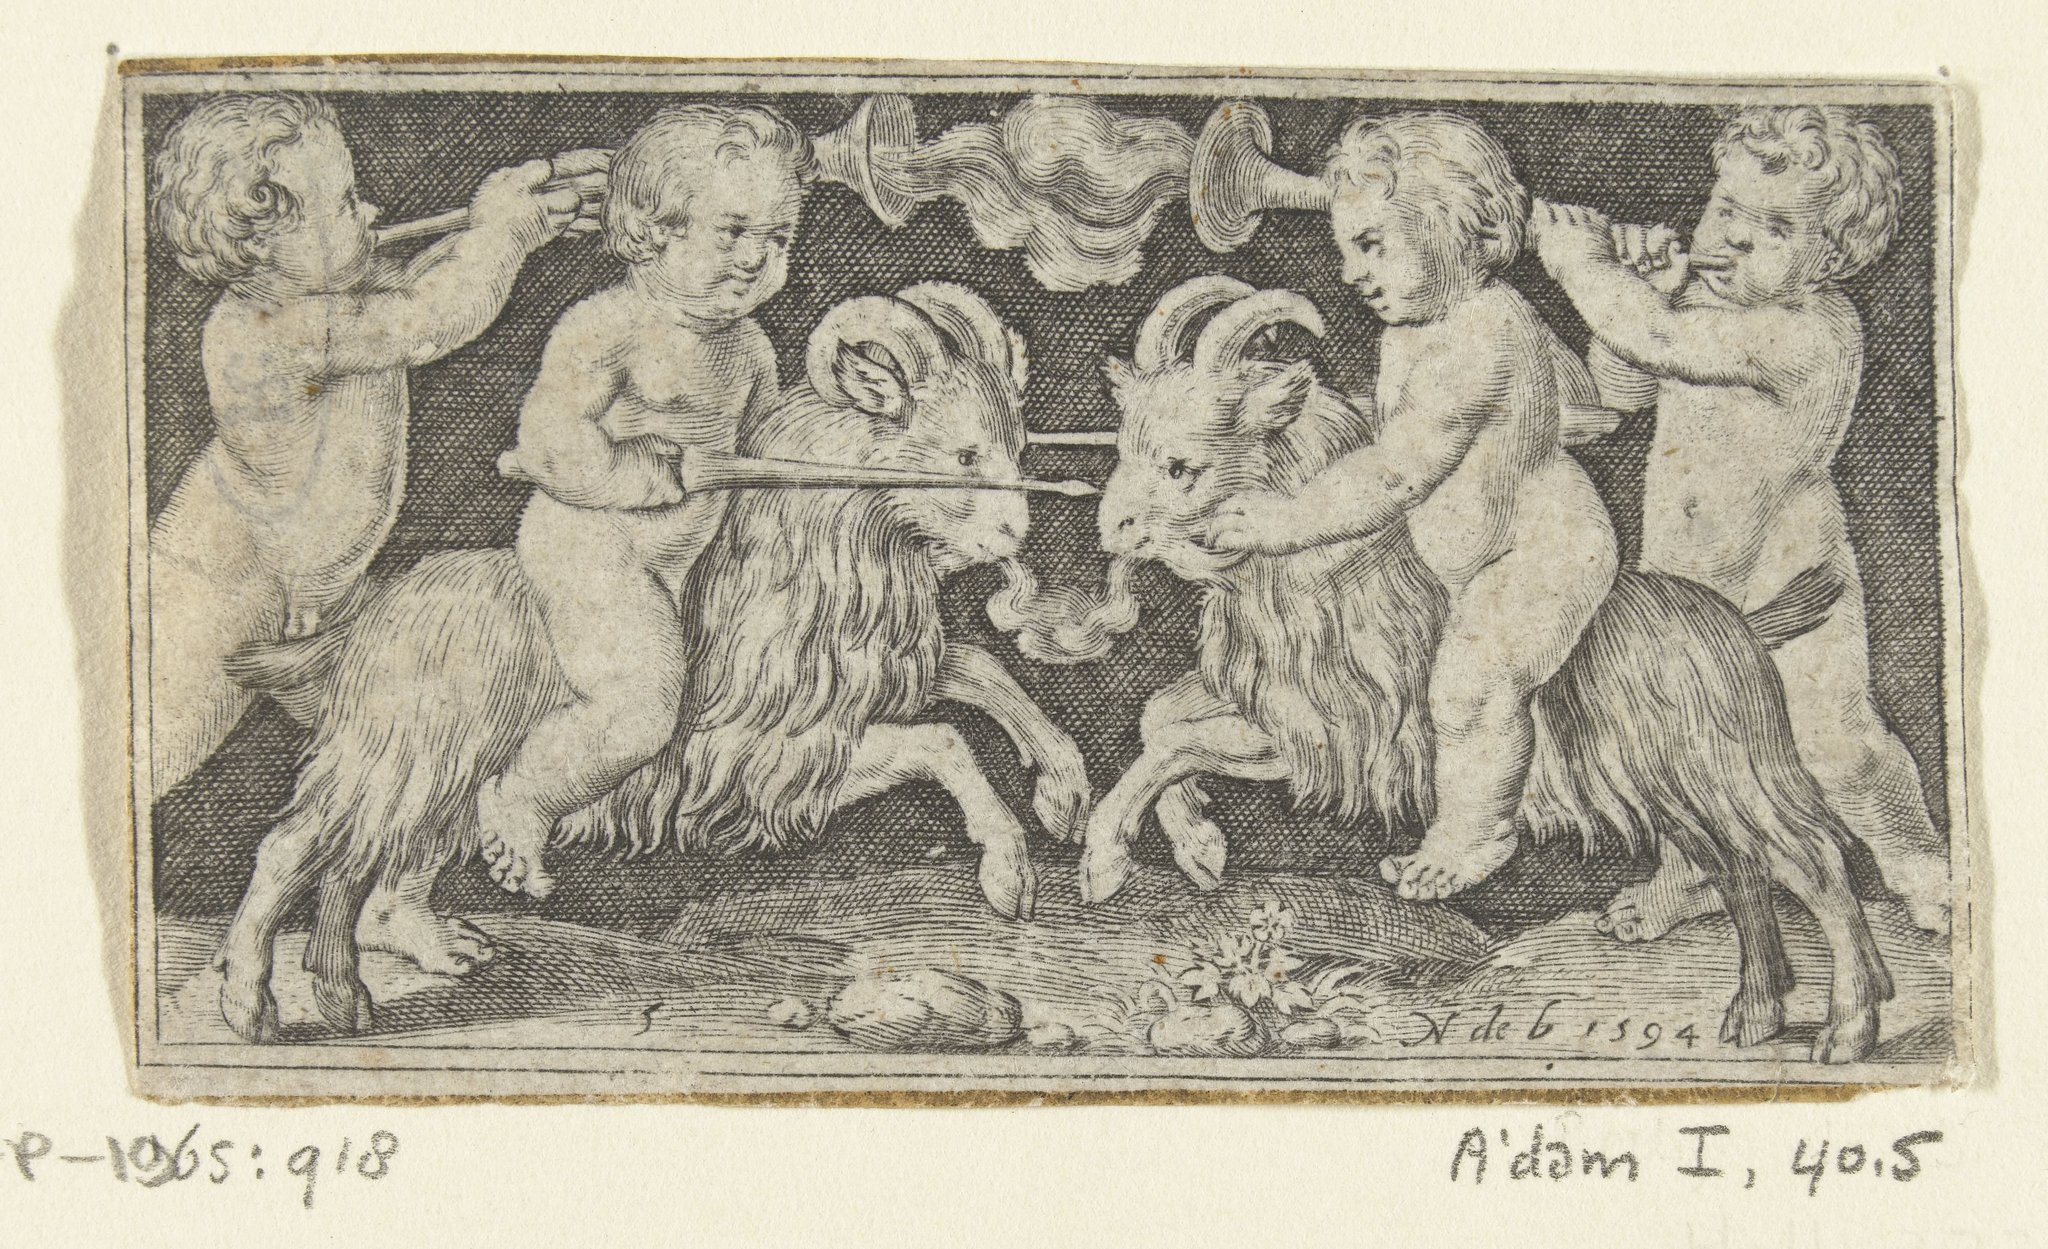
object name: print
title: Friezen met kinderen, engeltjes en dieren.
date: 1594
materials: paper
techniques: engraving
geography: netherlands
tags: goat, cupids: 'amores', 'amoretti', 'putti'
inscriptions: date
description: Blad 5 van serie van 6 genummerde bladen. Gearceerde achtergrond.